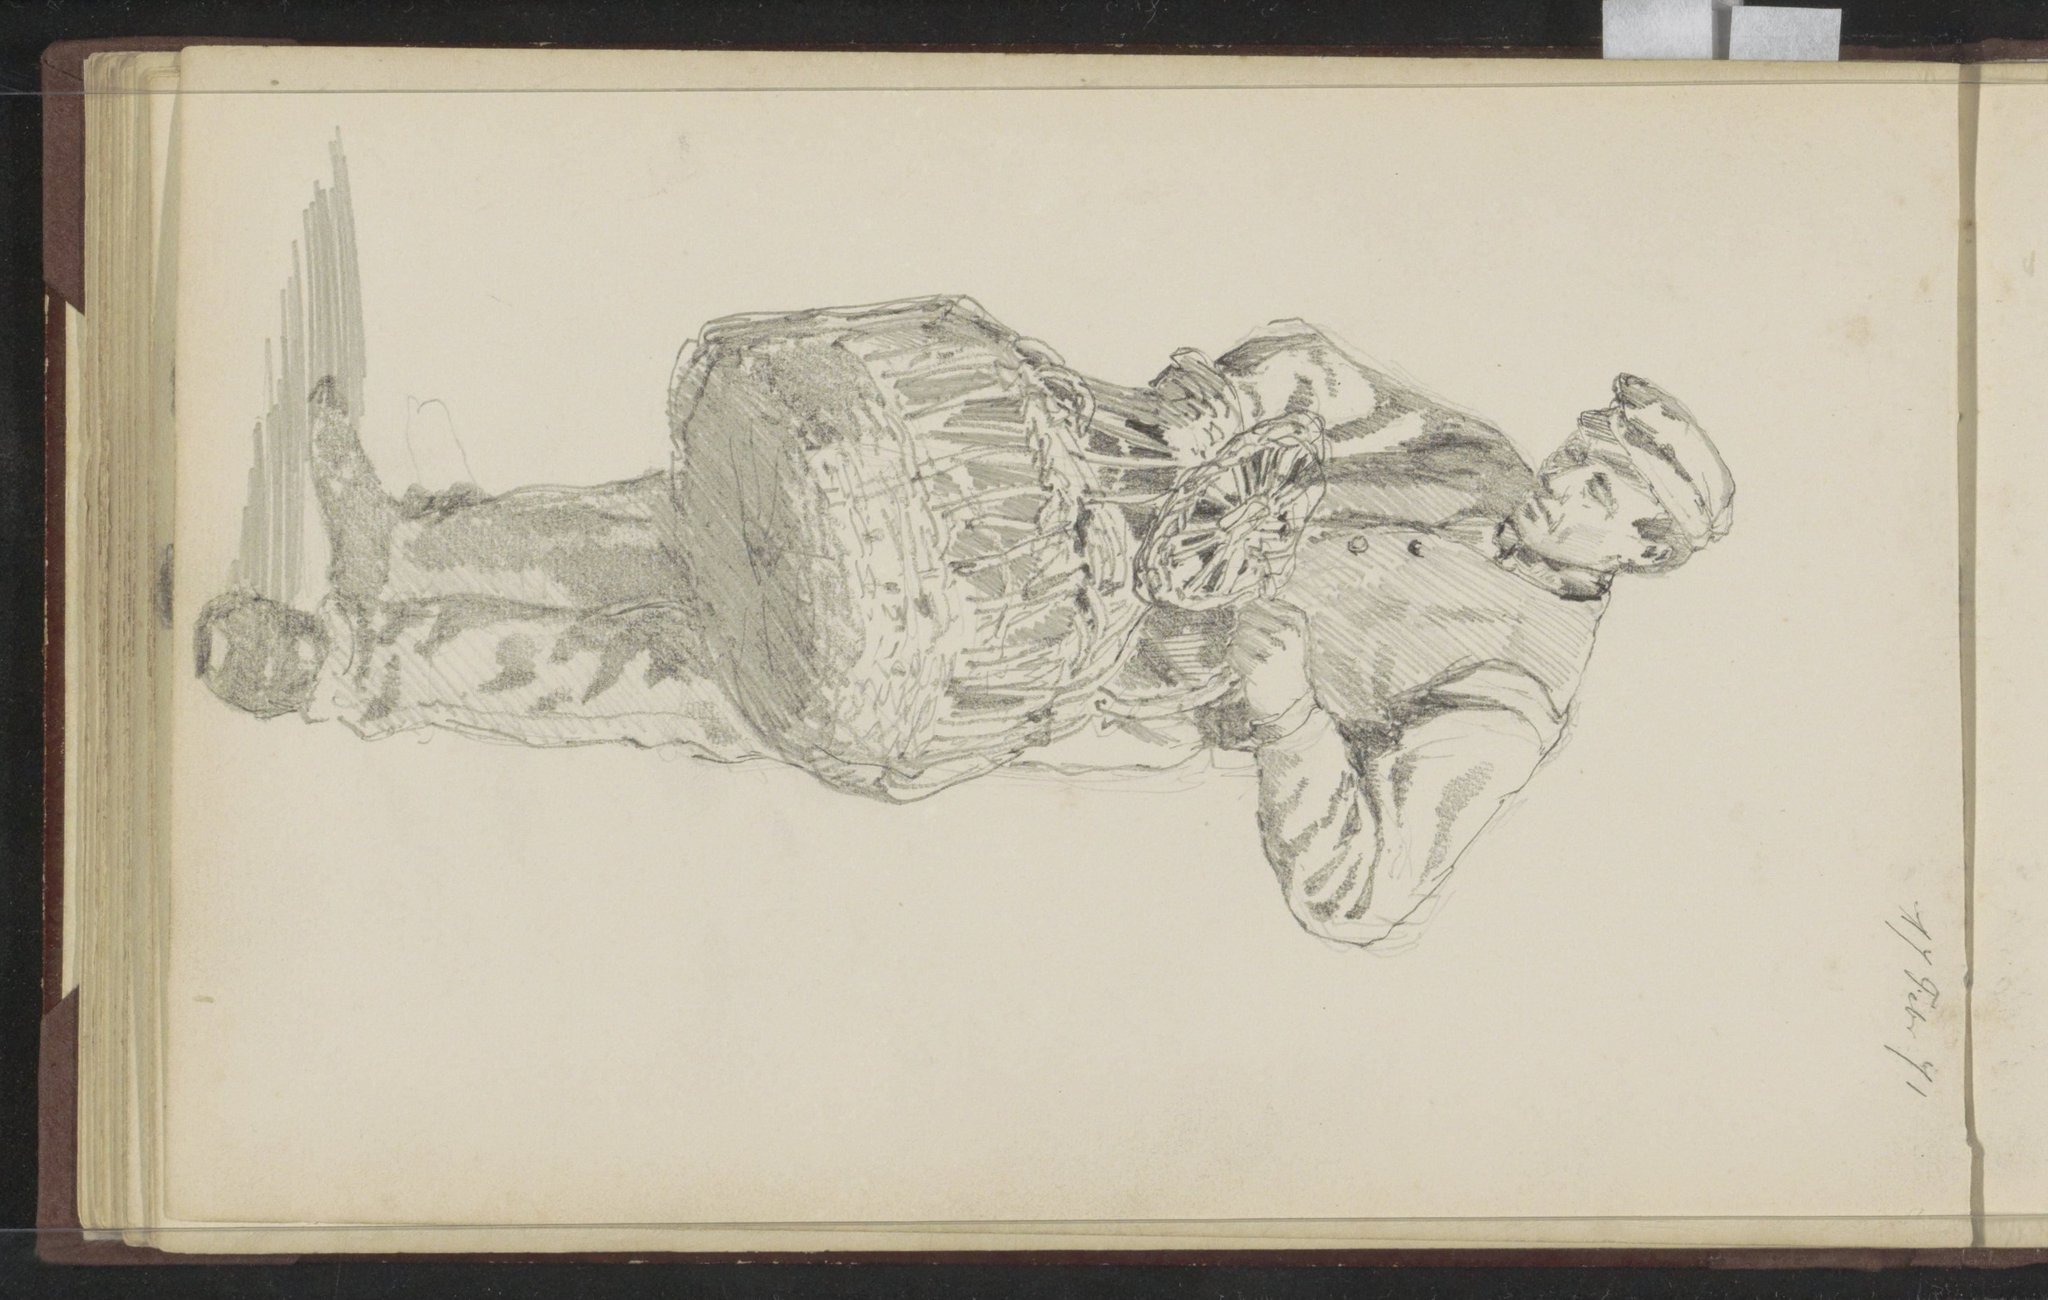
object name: sketchbook leaf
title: Man met een mand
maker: cornelis springer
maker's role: draughtsman, painter, print maker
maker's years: 1817-1891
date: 1871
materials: paper, pencil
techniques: stumping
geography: netherlands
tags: adult man, container made of plant material other than wood: basket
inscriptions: date: ‘17 Febr 71’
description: Man met een mand. Blad 22 verso uit een schetsboek met 39 bladen, deels vervaardigd te Ulm en Leiden.